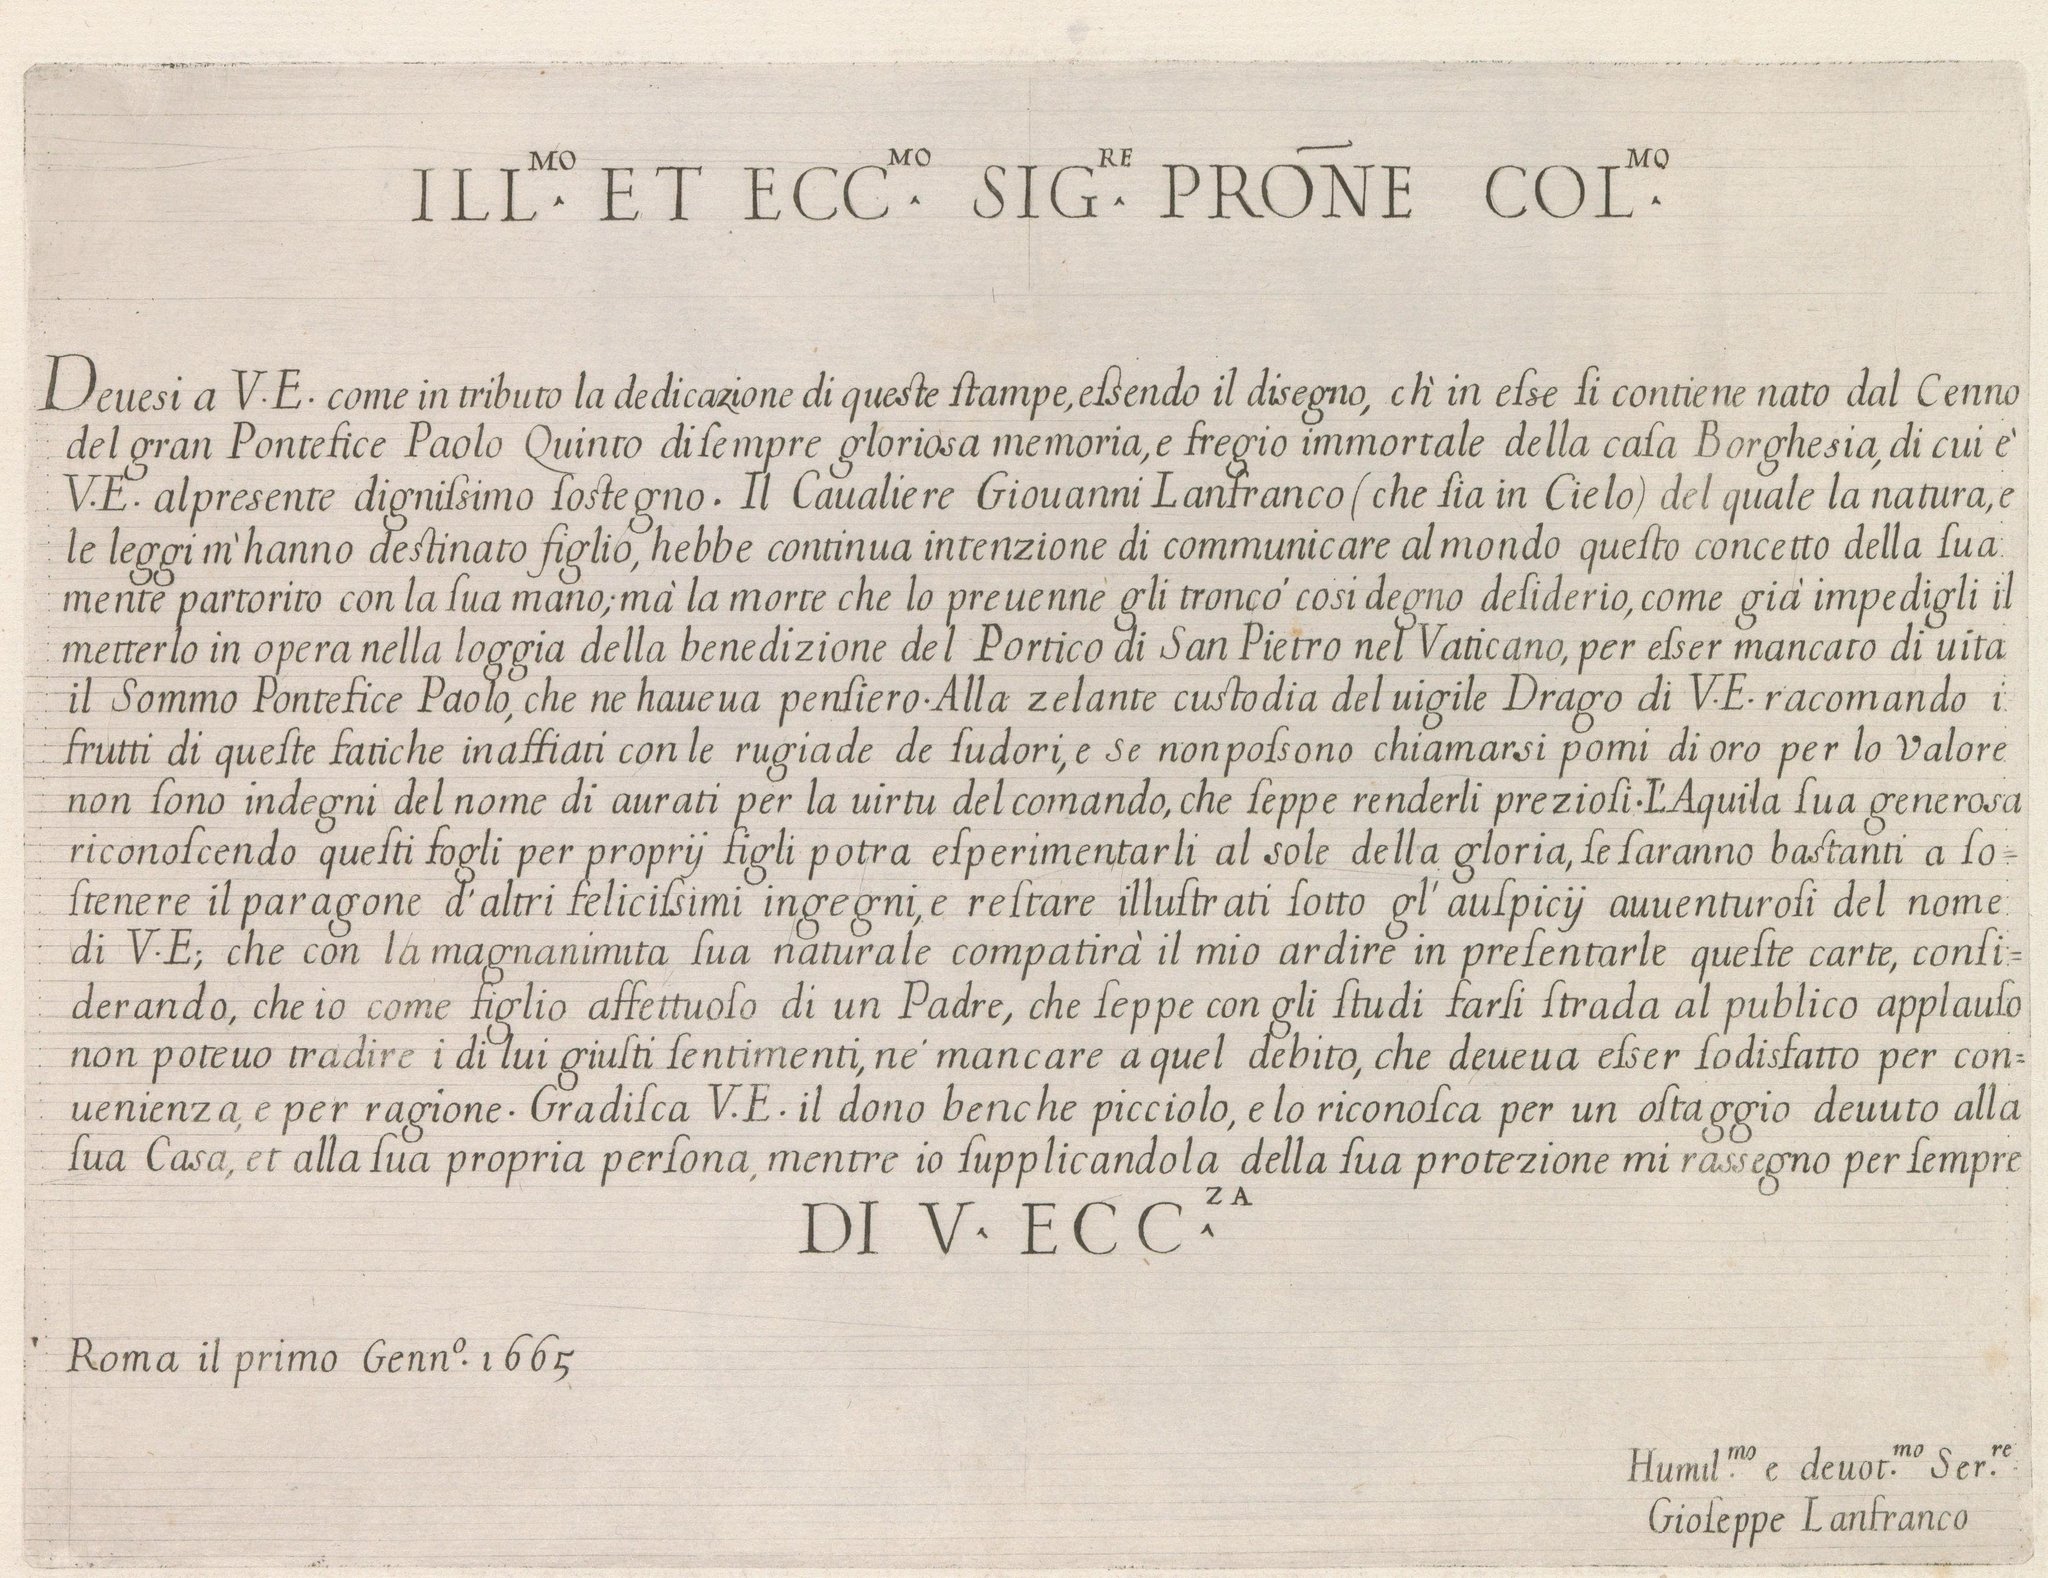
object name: album leaf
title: Opdracht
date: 1665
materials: paper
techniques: etching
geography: italy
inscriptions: inscription: ‘Ende lib. No. 1. fol. 9. lib. No. 21. fol. 8.’, number: ‘79’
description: Opdracht maakt deel uit van een reeks van vermoedelijk 21 prenten (in het Rijksmuseum bevinden zich 18 prenten) naar de ontwerpen van Giovanni Lanfranco voor schilderingen in de Loggia del Benedizione in het Vaticaan over de geschiedenis van Petrus en Paulus.